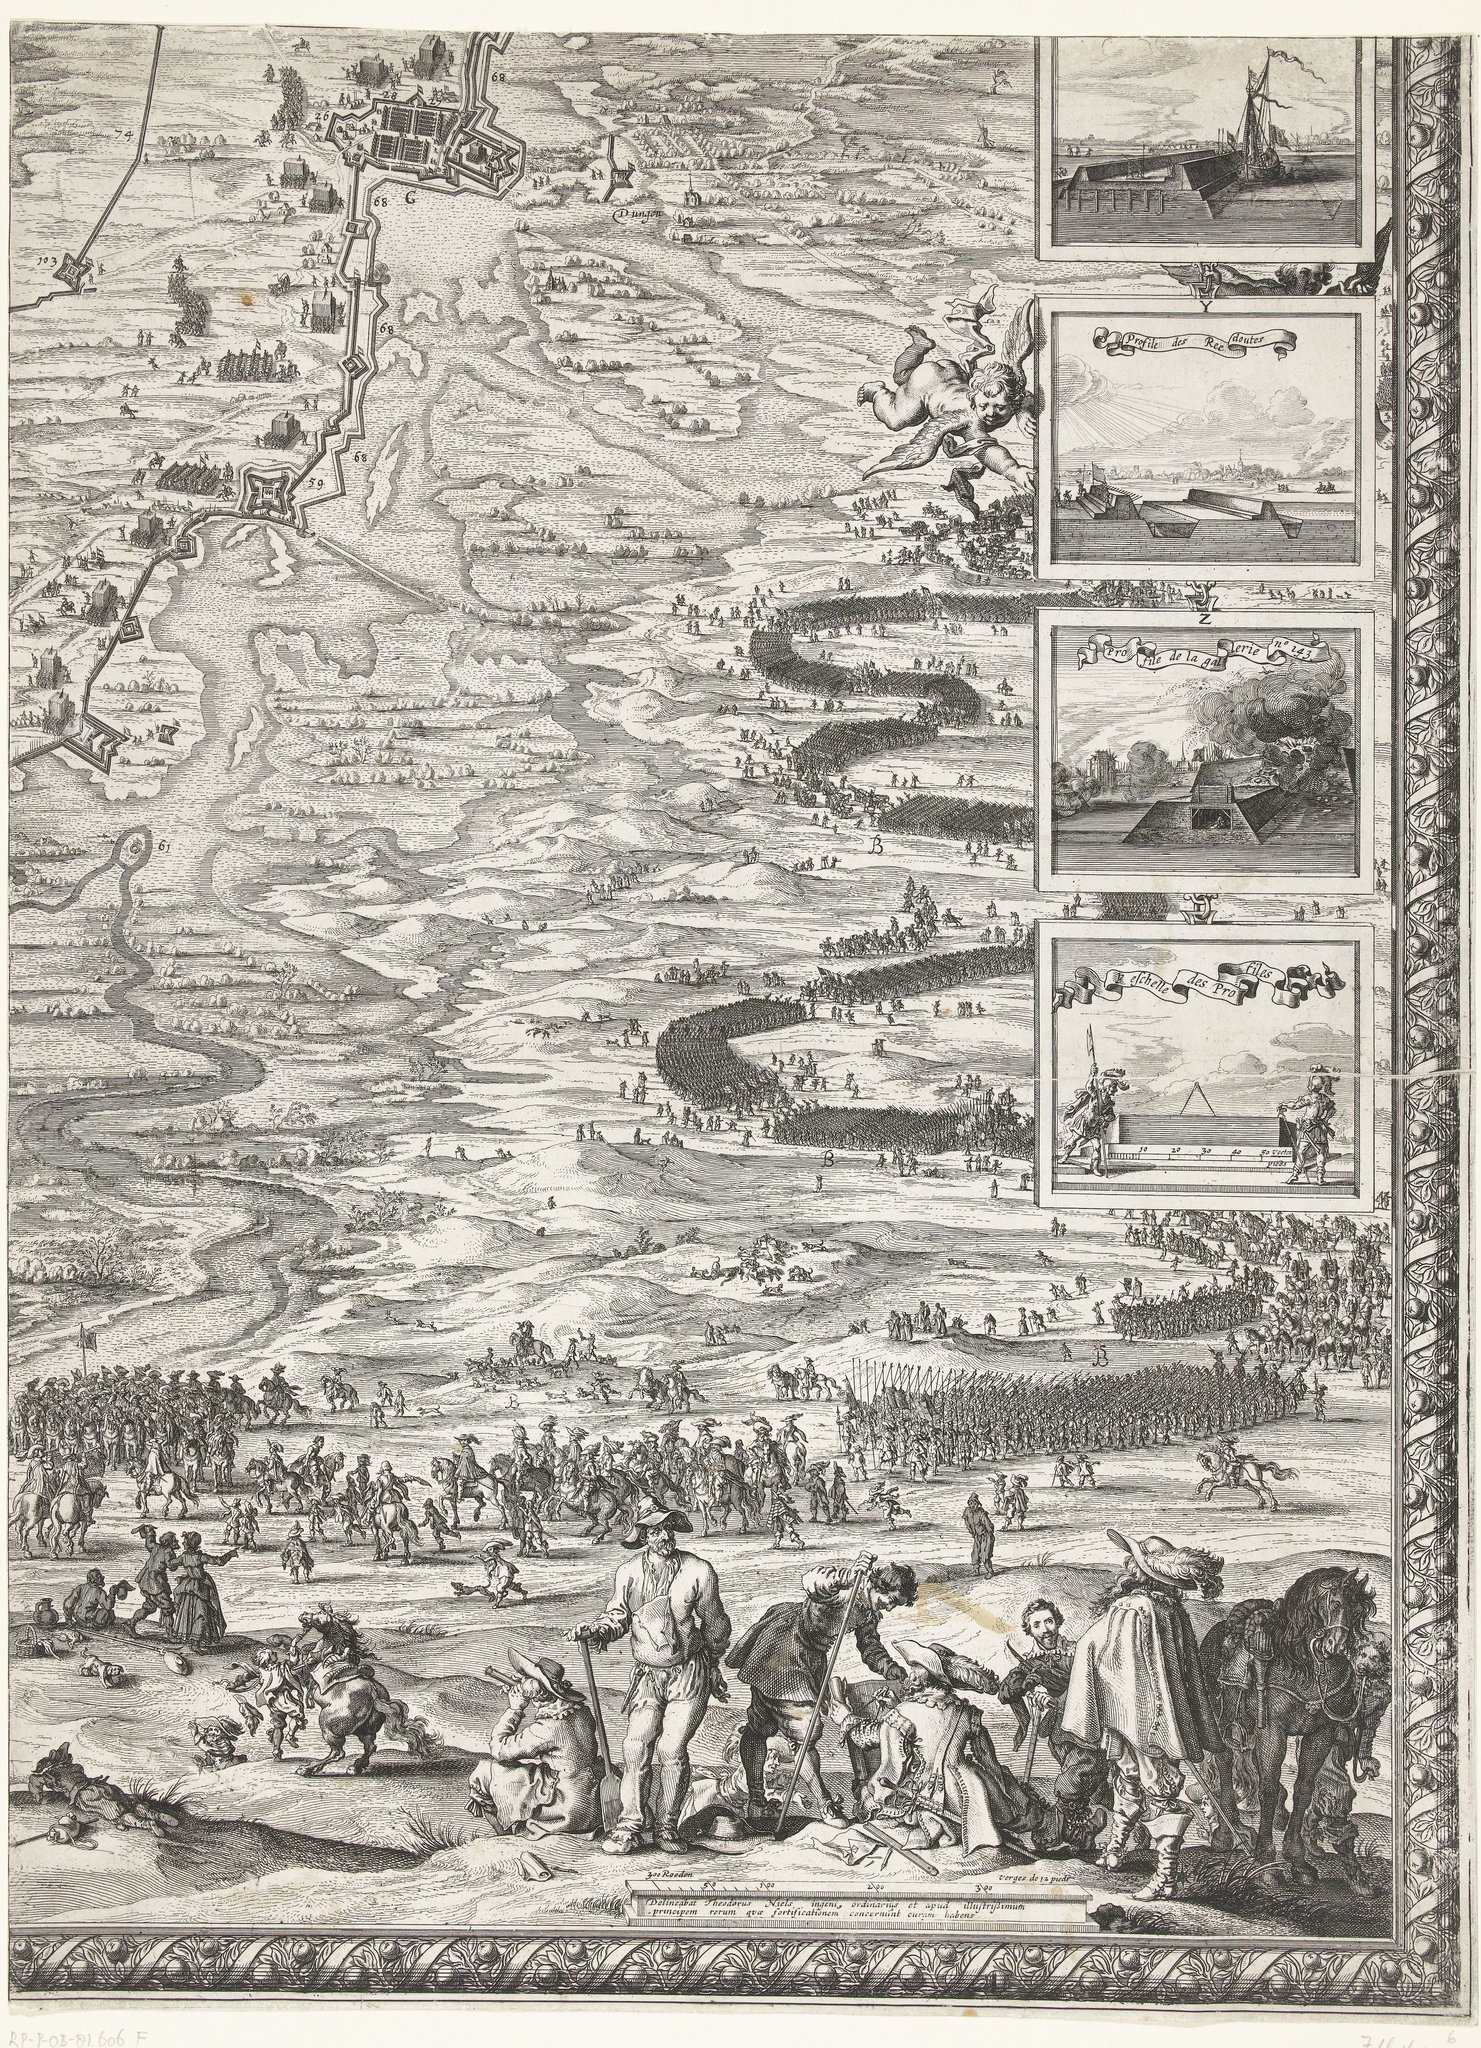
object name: print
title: Grote kaart van het beleg van Den Bosch door Frederik Hendrik (blad rechtsonder), 1629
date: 1629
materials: paper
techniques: etching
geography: northern netherlands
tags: frederick henry (prince of orange), maps of separate countries or regions, siege, position war, den bosch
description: Grote kaart van het beleg van Den Bosch door het Staatse leger onder Frederik Hendrik, van 1 mei tot 17 september 1629. Aan weerszijden van de kaart 18 kleine voorstellingen met details van de versterkingen van de stad en omliggende forten gemerkt I-Z.. Kaart samengesteld uit zes platen en twee - ontbrekende - tekstbladen. Dit is het blad rechtsonder met een deel van de kaart met de omsingeling. Op de voorgrond zijn enkele landmeters aan het werk.